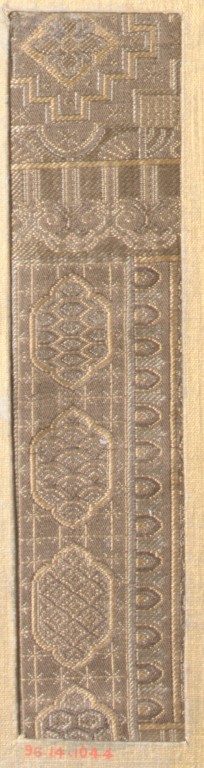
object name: piece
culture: japanese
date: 1701-1900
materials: silk